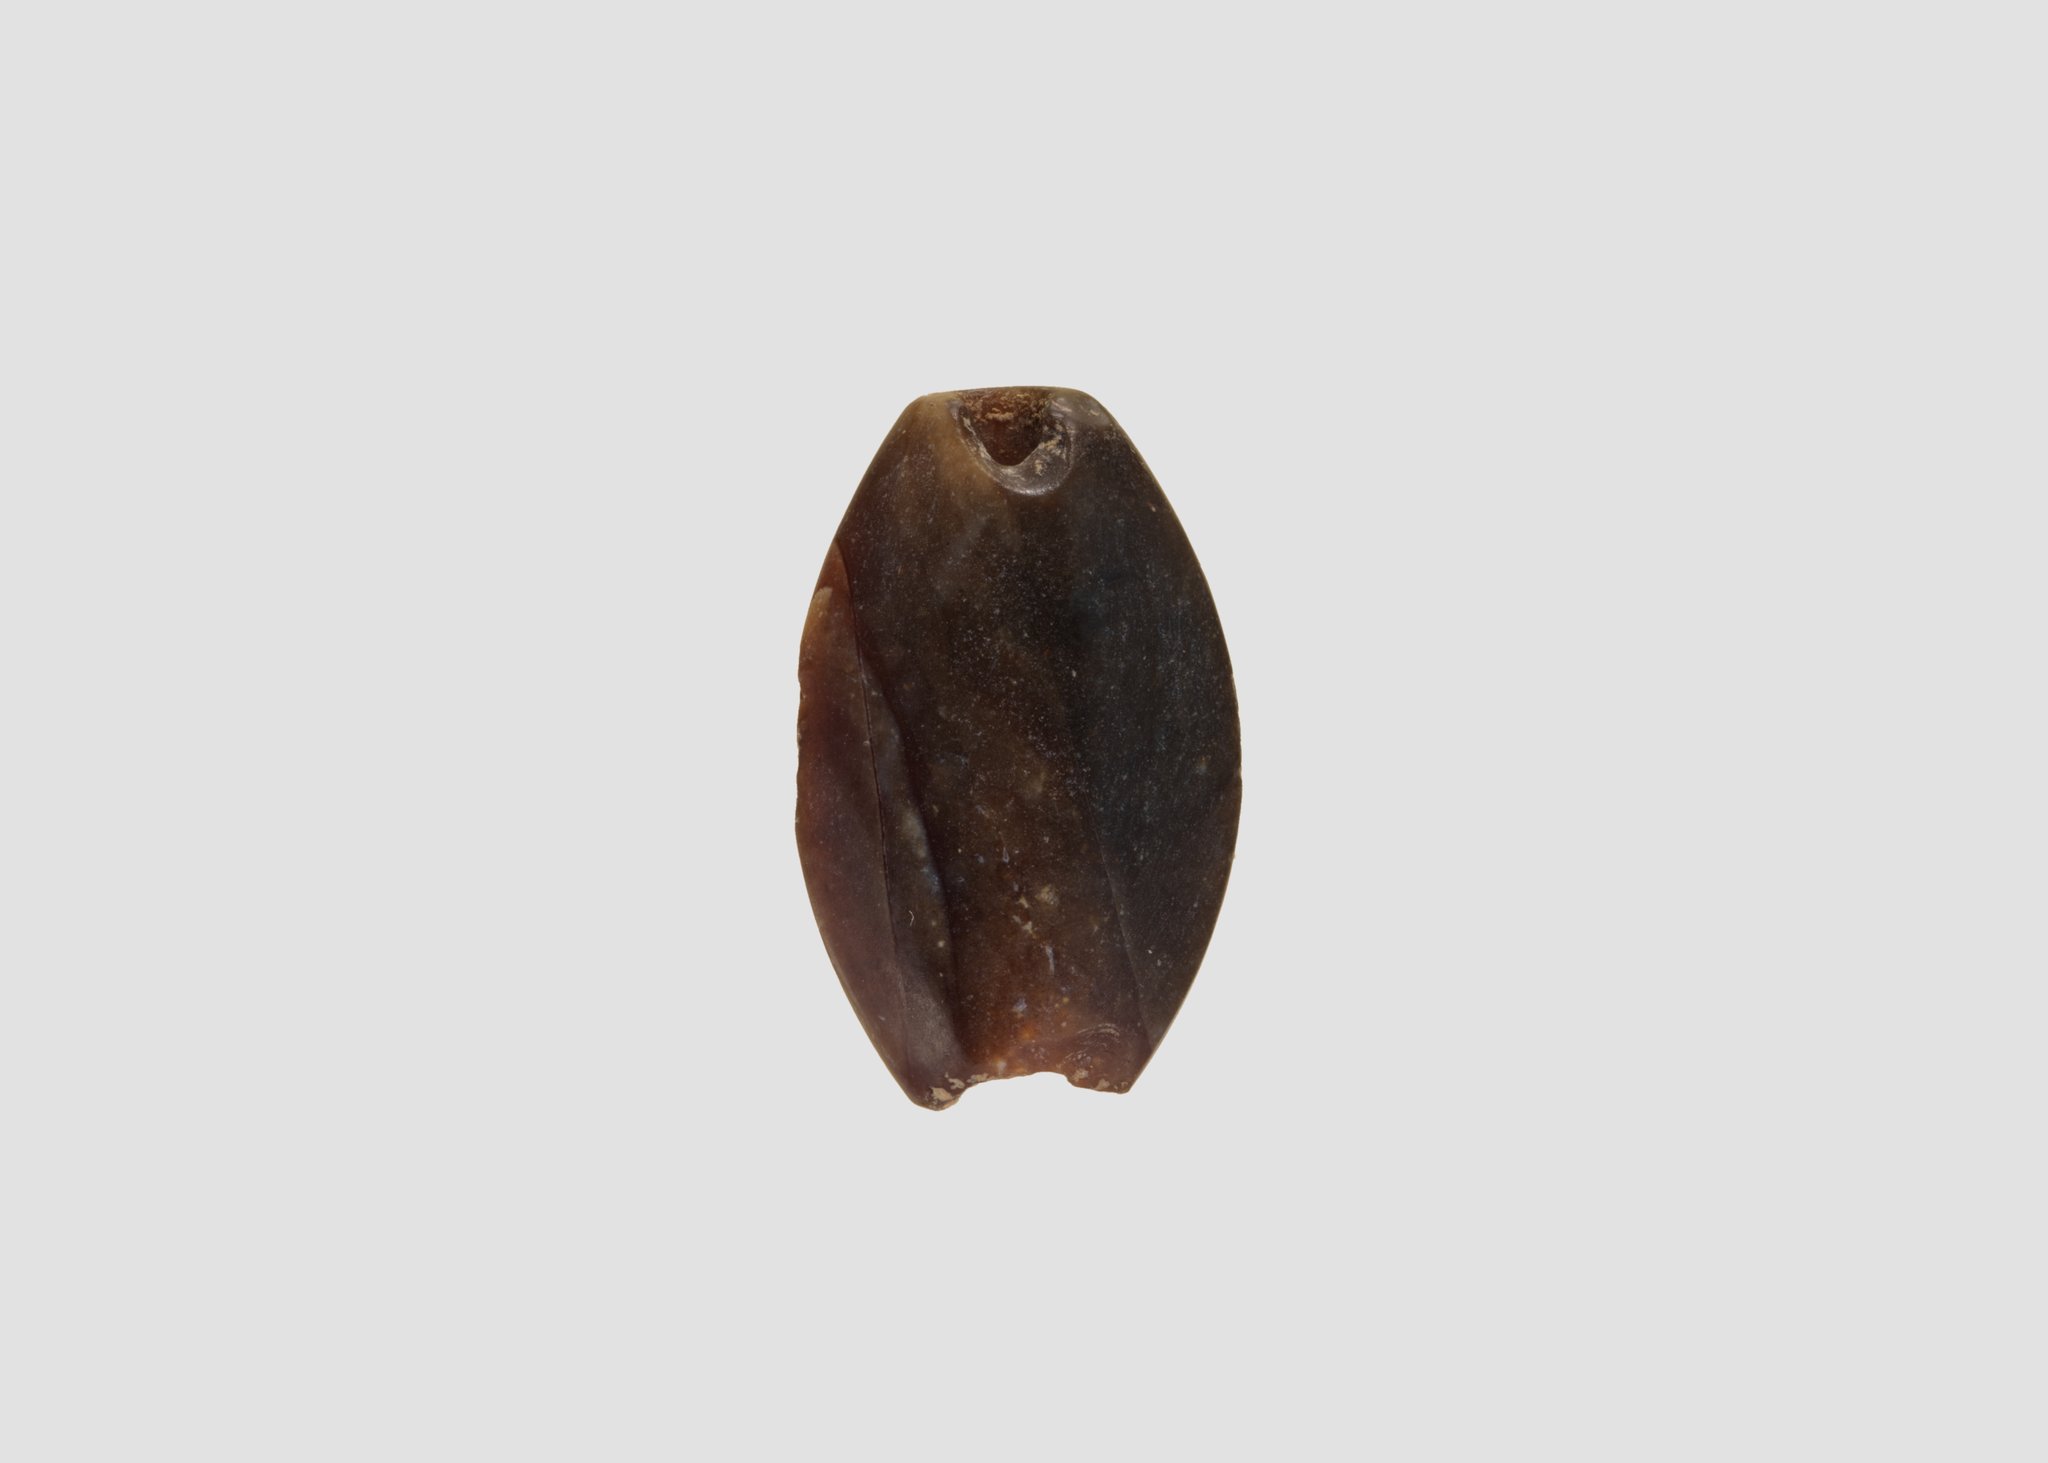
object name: bead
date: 7000-5001 BCE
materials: jasper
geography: syria